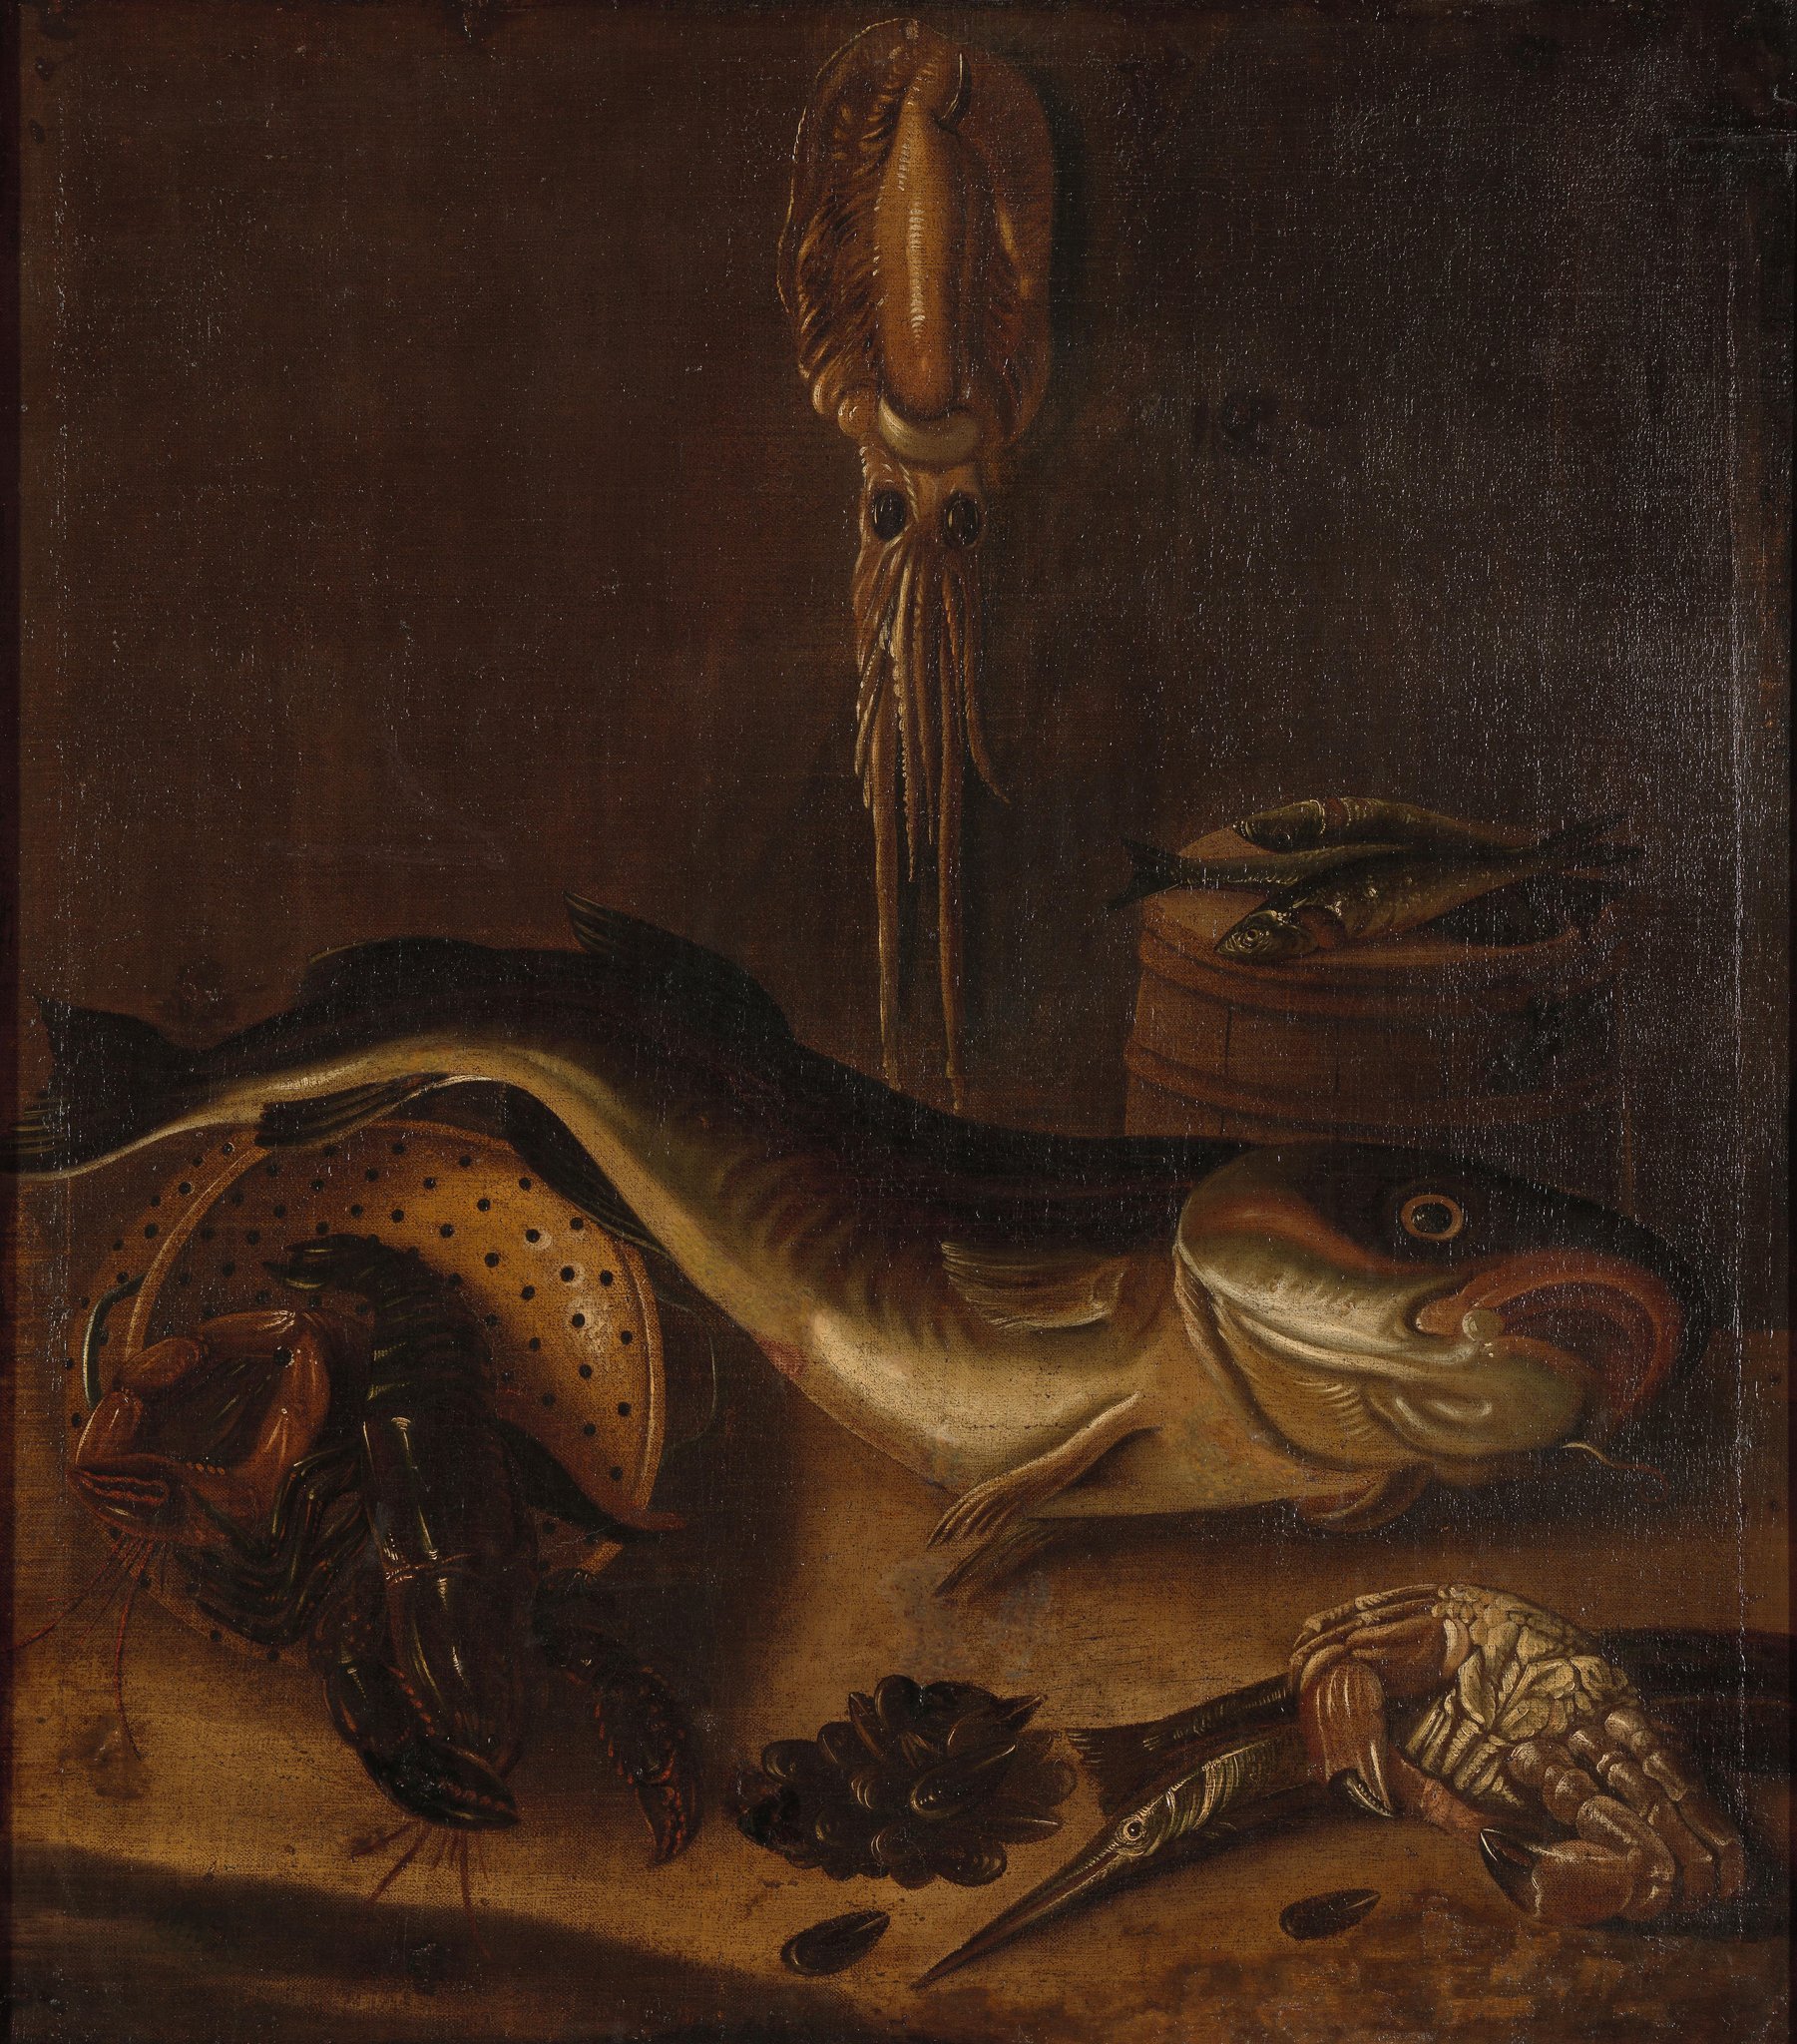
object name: painting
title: Still Life with Fish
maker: a. van doeff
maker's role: painter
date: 1625-1675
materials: canvas, oil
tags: fishes, still life of related objects, foodstuffs; still life of foodstuffs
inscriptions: signature: ‘ADoeff’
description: Visstilleven. Op tafel liggen een kabeljauw, een krab op een vergiet, mosselen en een geek. Een inktvis hangt aan een haak aan de muur, op een ton liggen enkele haringen.